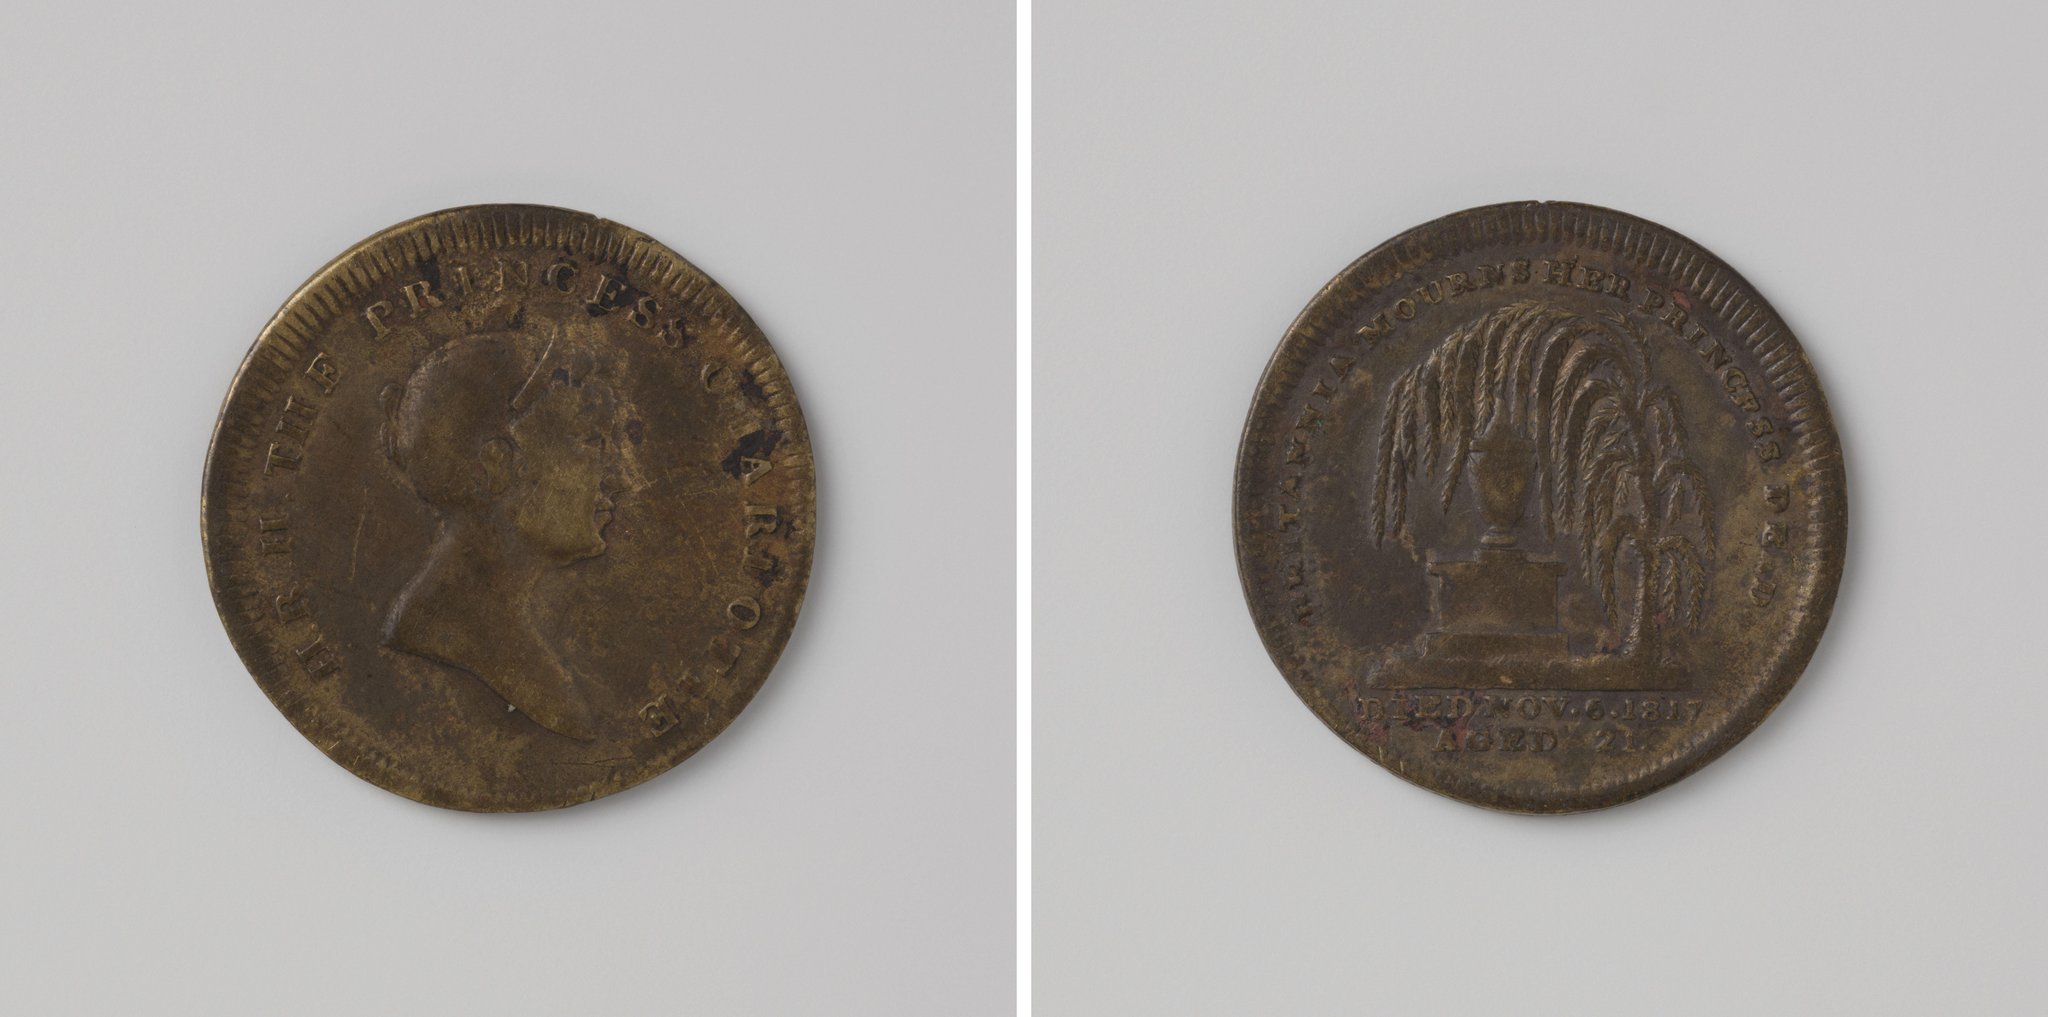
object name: jeton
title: Overlijden van Charlotte Augusta, prinses van Engeland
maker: Anonymous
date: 1817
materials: copper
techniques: striking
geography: england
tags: charlotte augusta (prinses van wales)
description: Koperen penning. Voorzijde: borststuk vrouw met diadeem binnen omschrift. Keerzijde: lijkbus op sokkel, staande onder boom waarvan takken slap hangen binnen omschrift; afsnede: opschrift